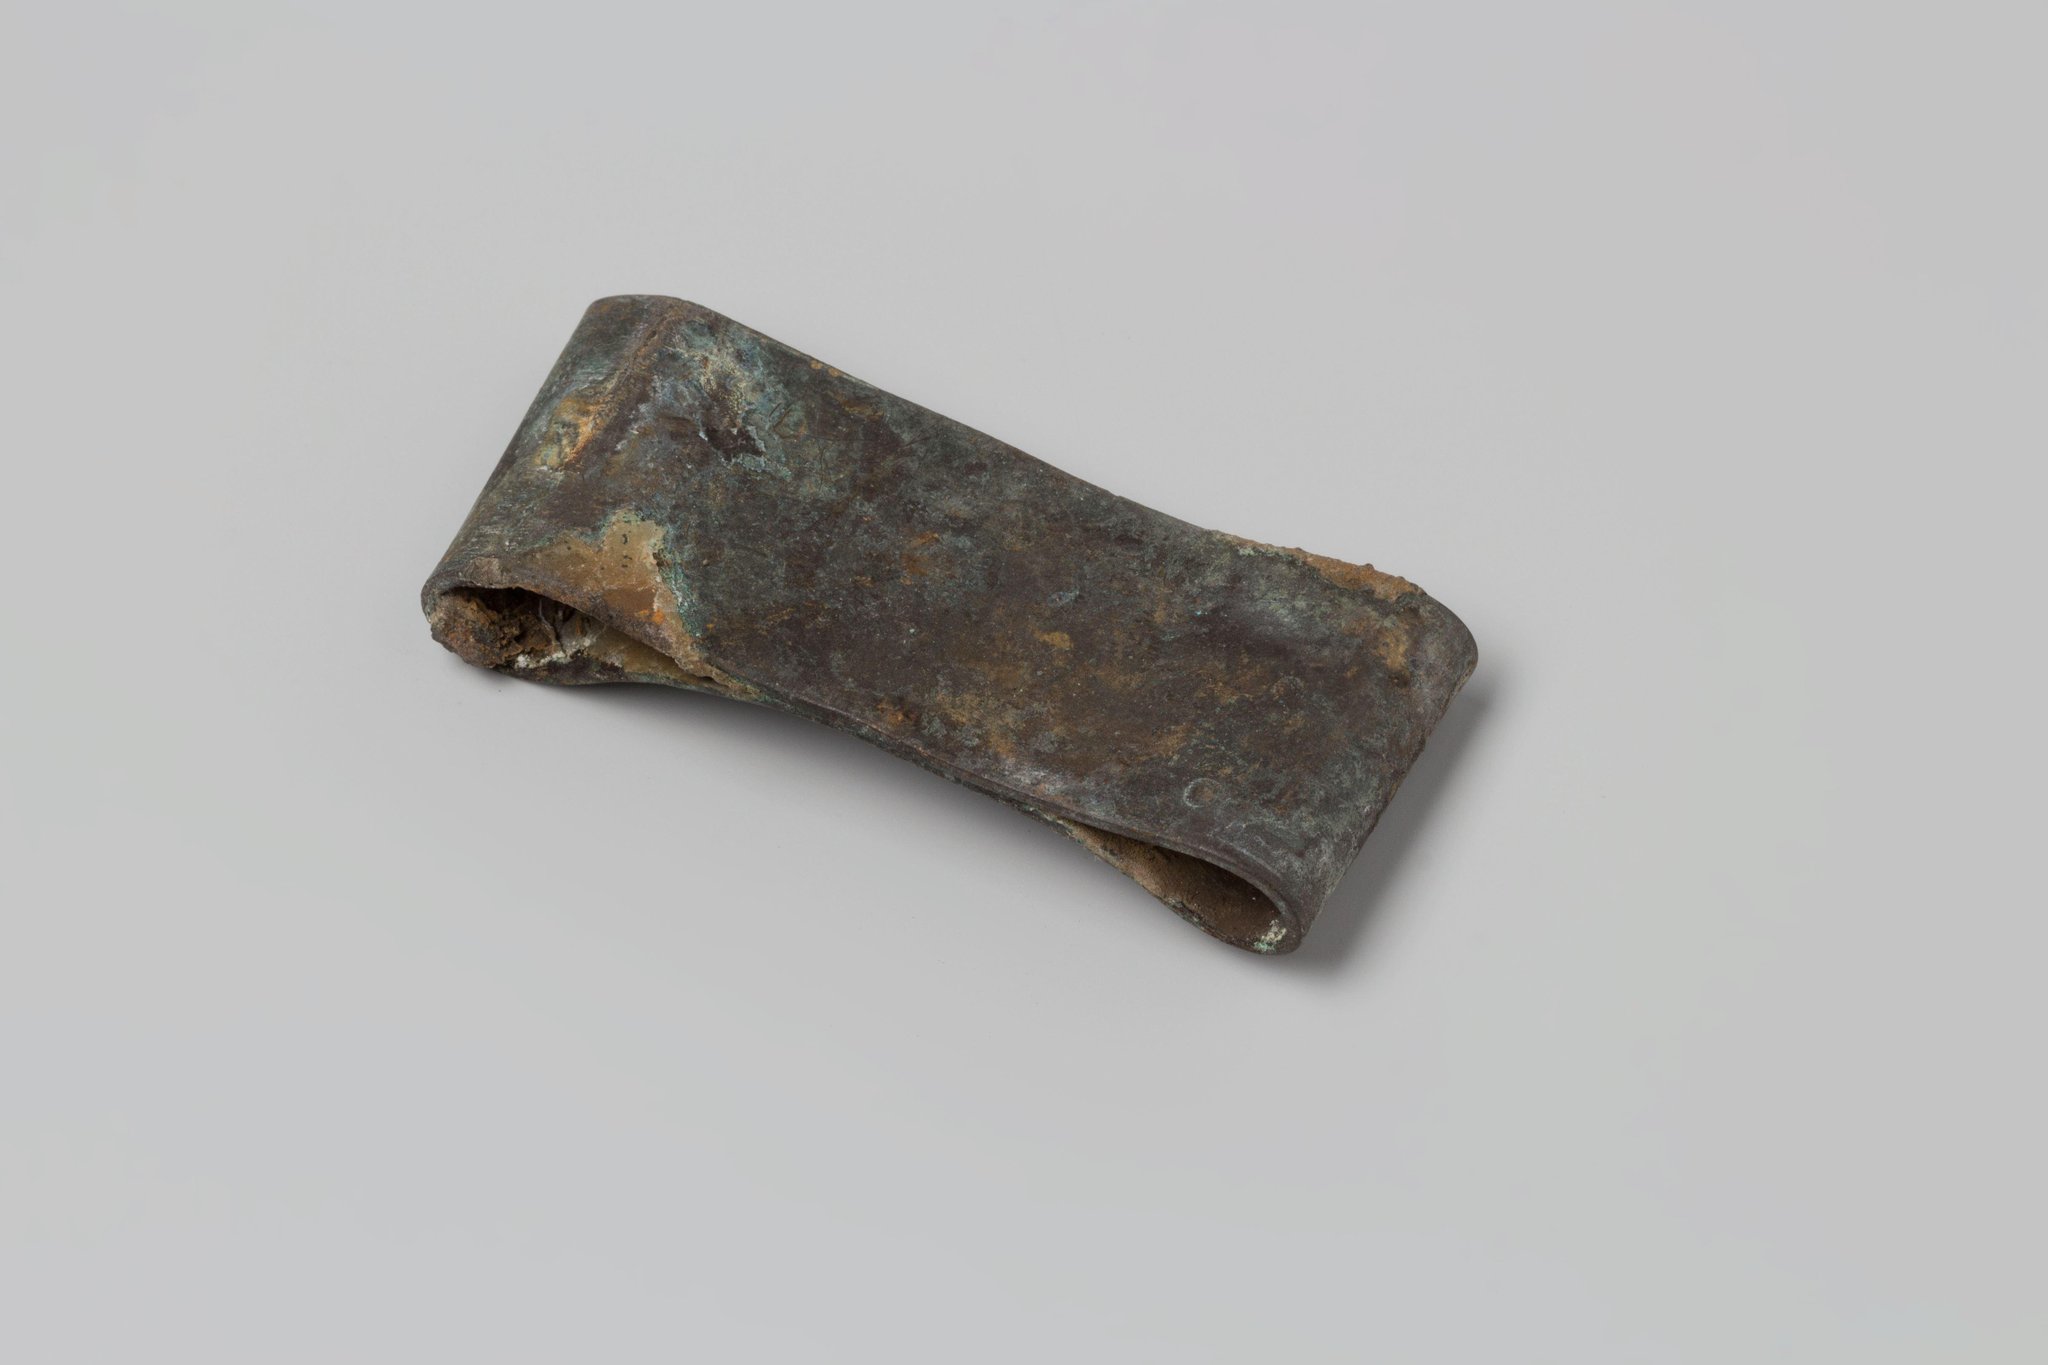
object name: firehose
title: Fragment van brandslangringen uit het wrak van de Oost-Indiëvaarder Hollandia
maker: Anonymous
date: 1700-1743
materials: copper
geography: netherlands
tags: verenigde oostindische compagnie, hollandia (schip), annet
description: Fire engine, firehose; fragments, id. NG-1975-20-H-1271-a, squashed.